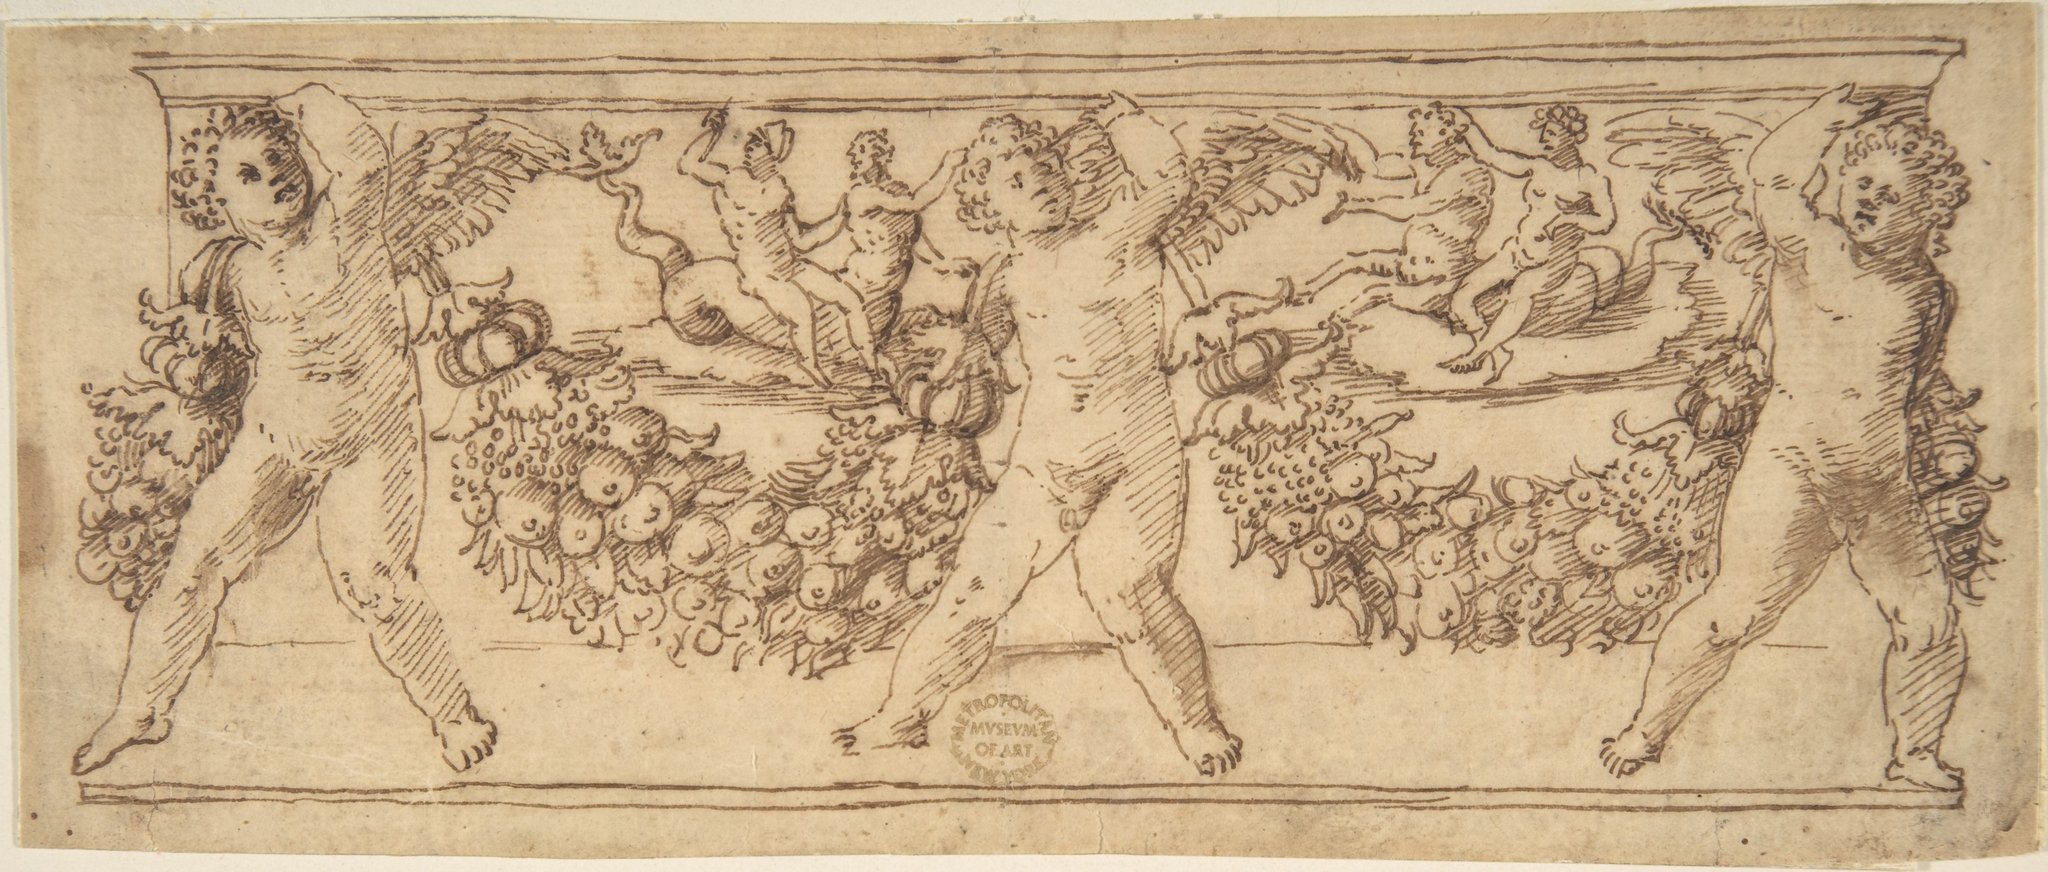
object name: drawing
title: Sarcophagus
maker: anonymous, italian, 16th century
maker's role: artist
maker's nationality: italian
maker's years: 1550-1600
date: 1501-1600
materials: ink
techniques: pen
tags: garlands,putti